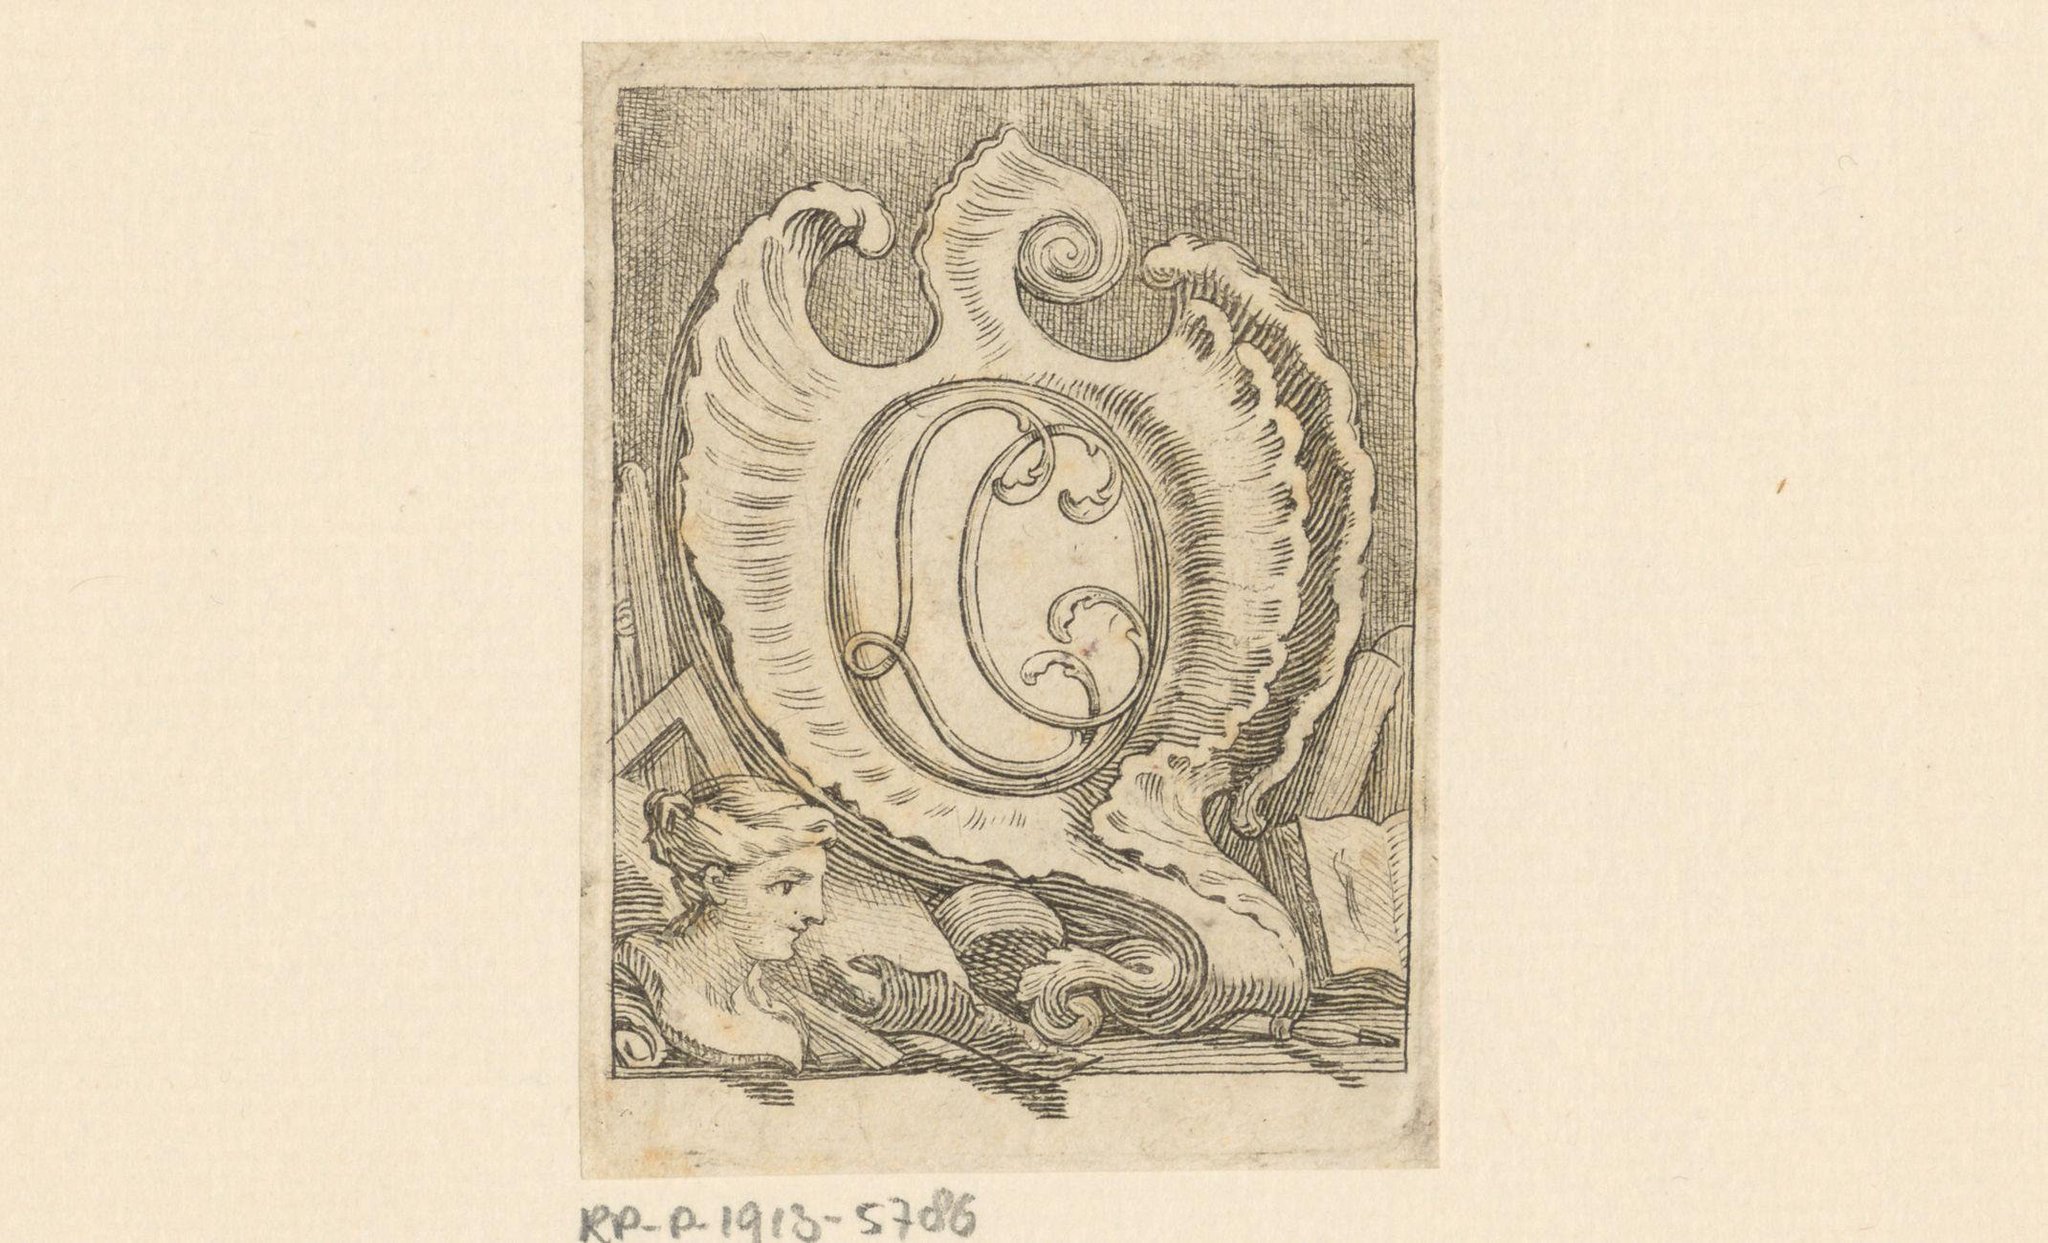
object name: bookplate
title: Ex libris van L.C.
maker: Anonymous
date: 1700-1800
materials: paper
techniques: engraving, etching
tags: rocaille ornament, book, tools, implements of architect, chest, bust - aa - female human figure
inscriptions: inscription: ‘Ex libris journal II 90’, collector's mark: Lugt 2760, collector's mark: Lugt 2233